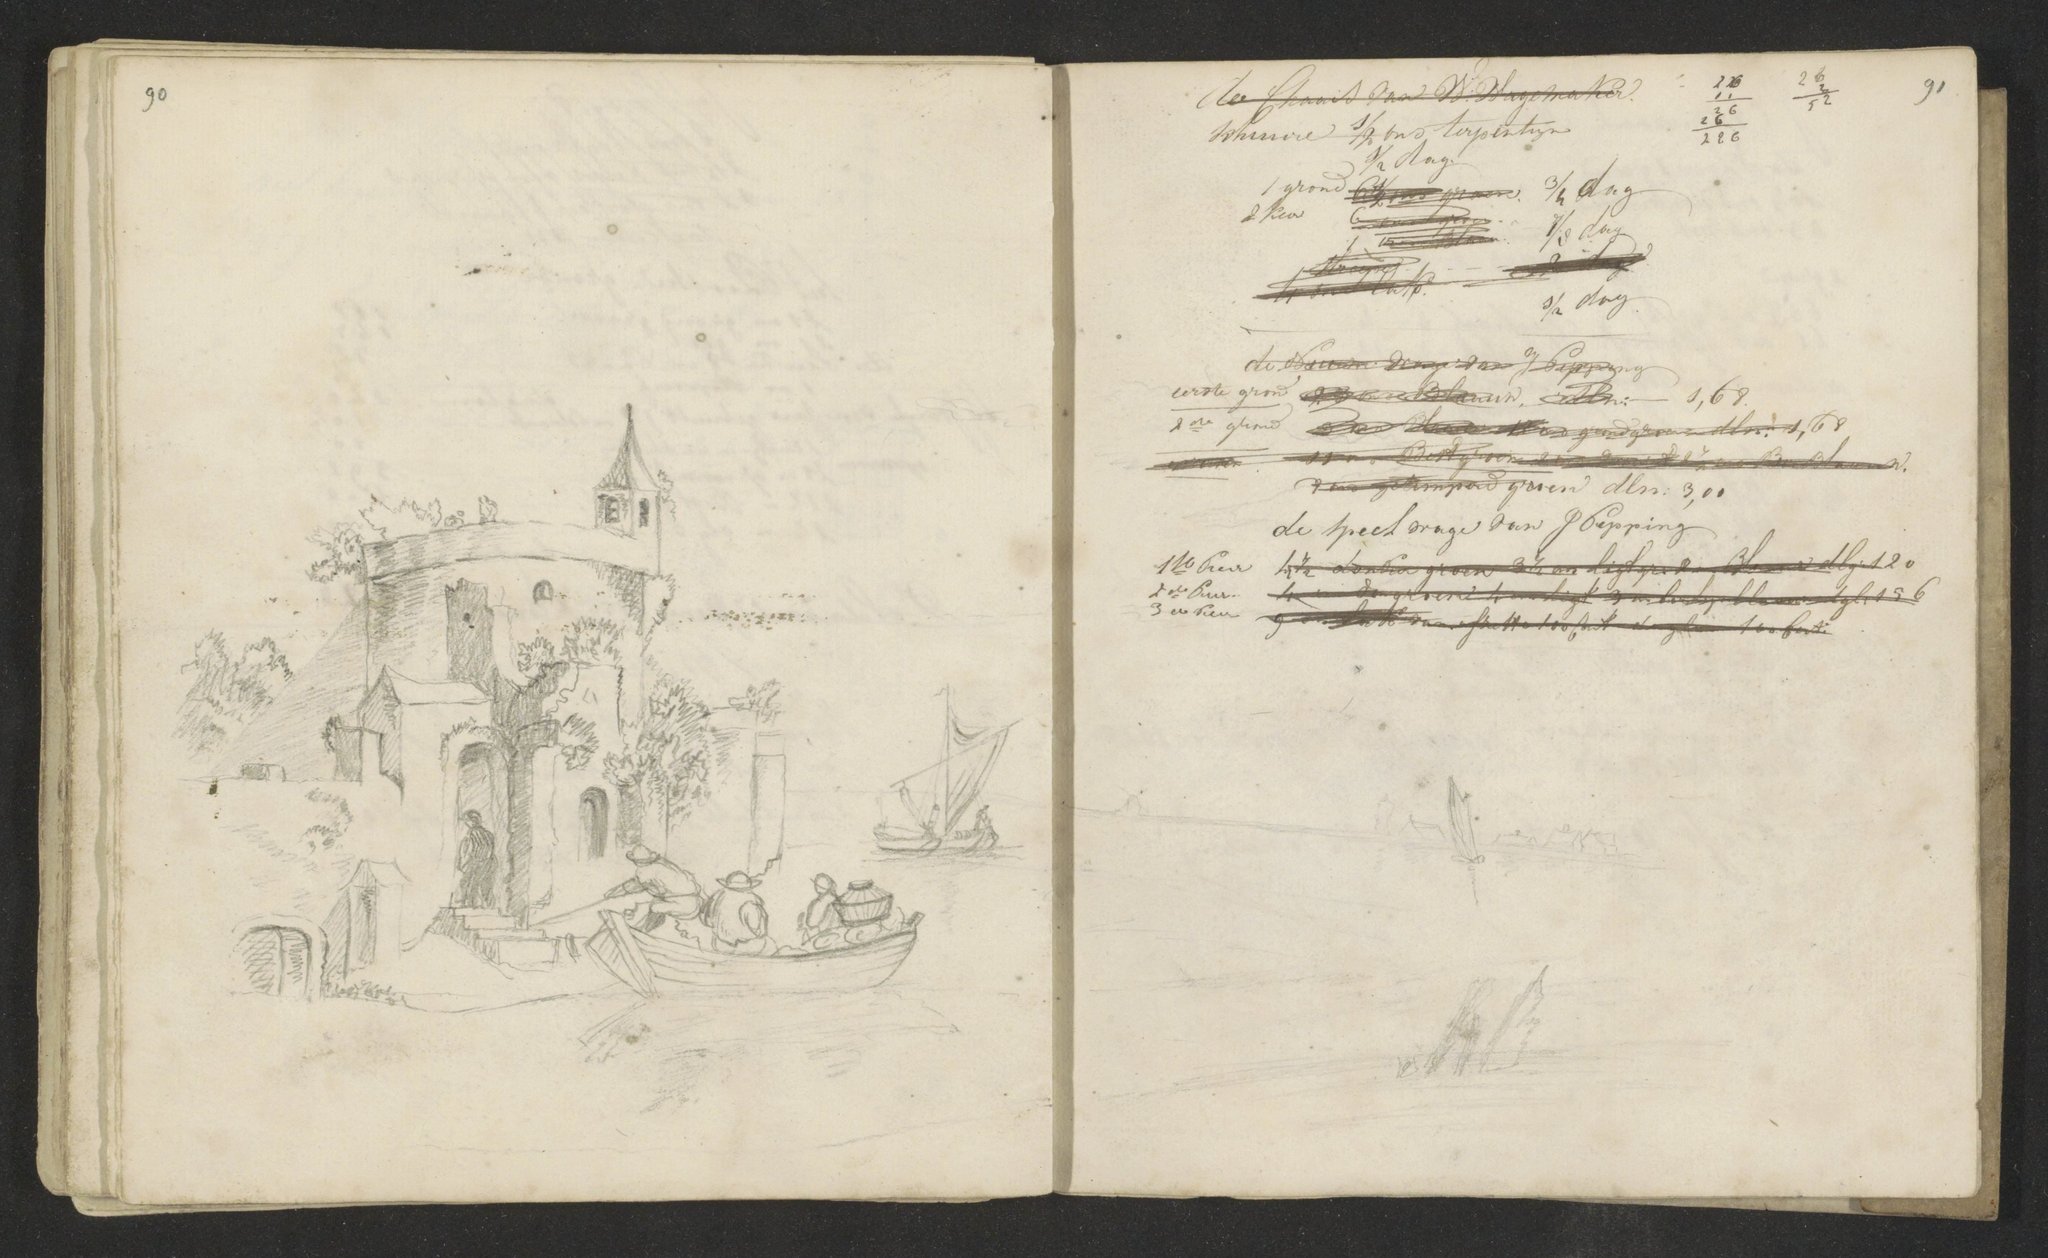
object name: sketchbook leaf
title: Landschap met boten op het water en een toren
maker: Anonymous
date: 1840-1860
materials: paper, pencil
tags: river bank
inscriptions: annotation: ‘...’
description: Bladzijde 90 en 91 uit een schetsboek met 96 bladzijden.